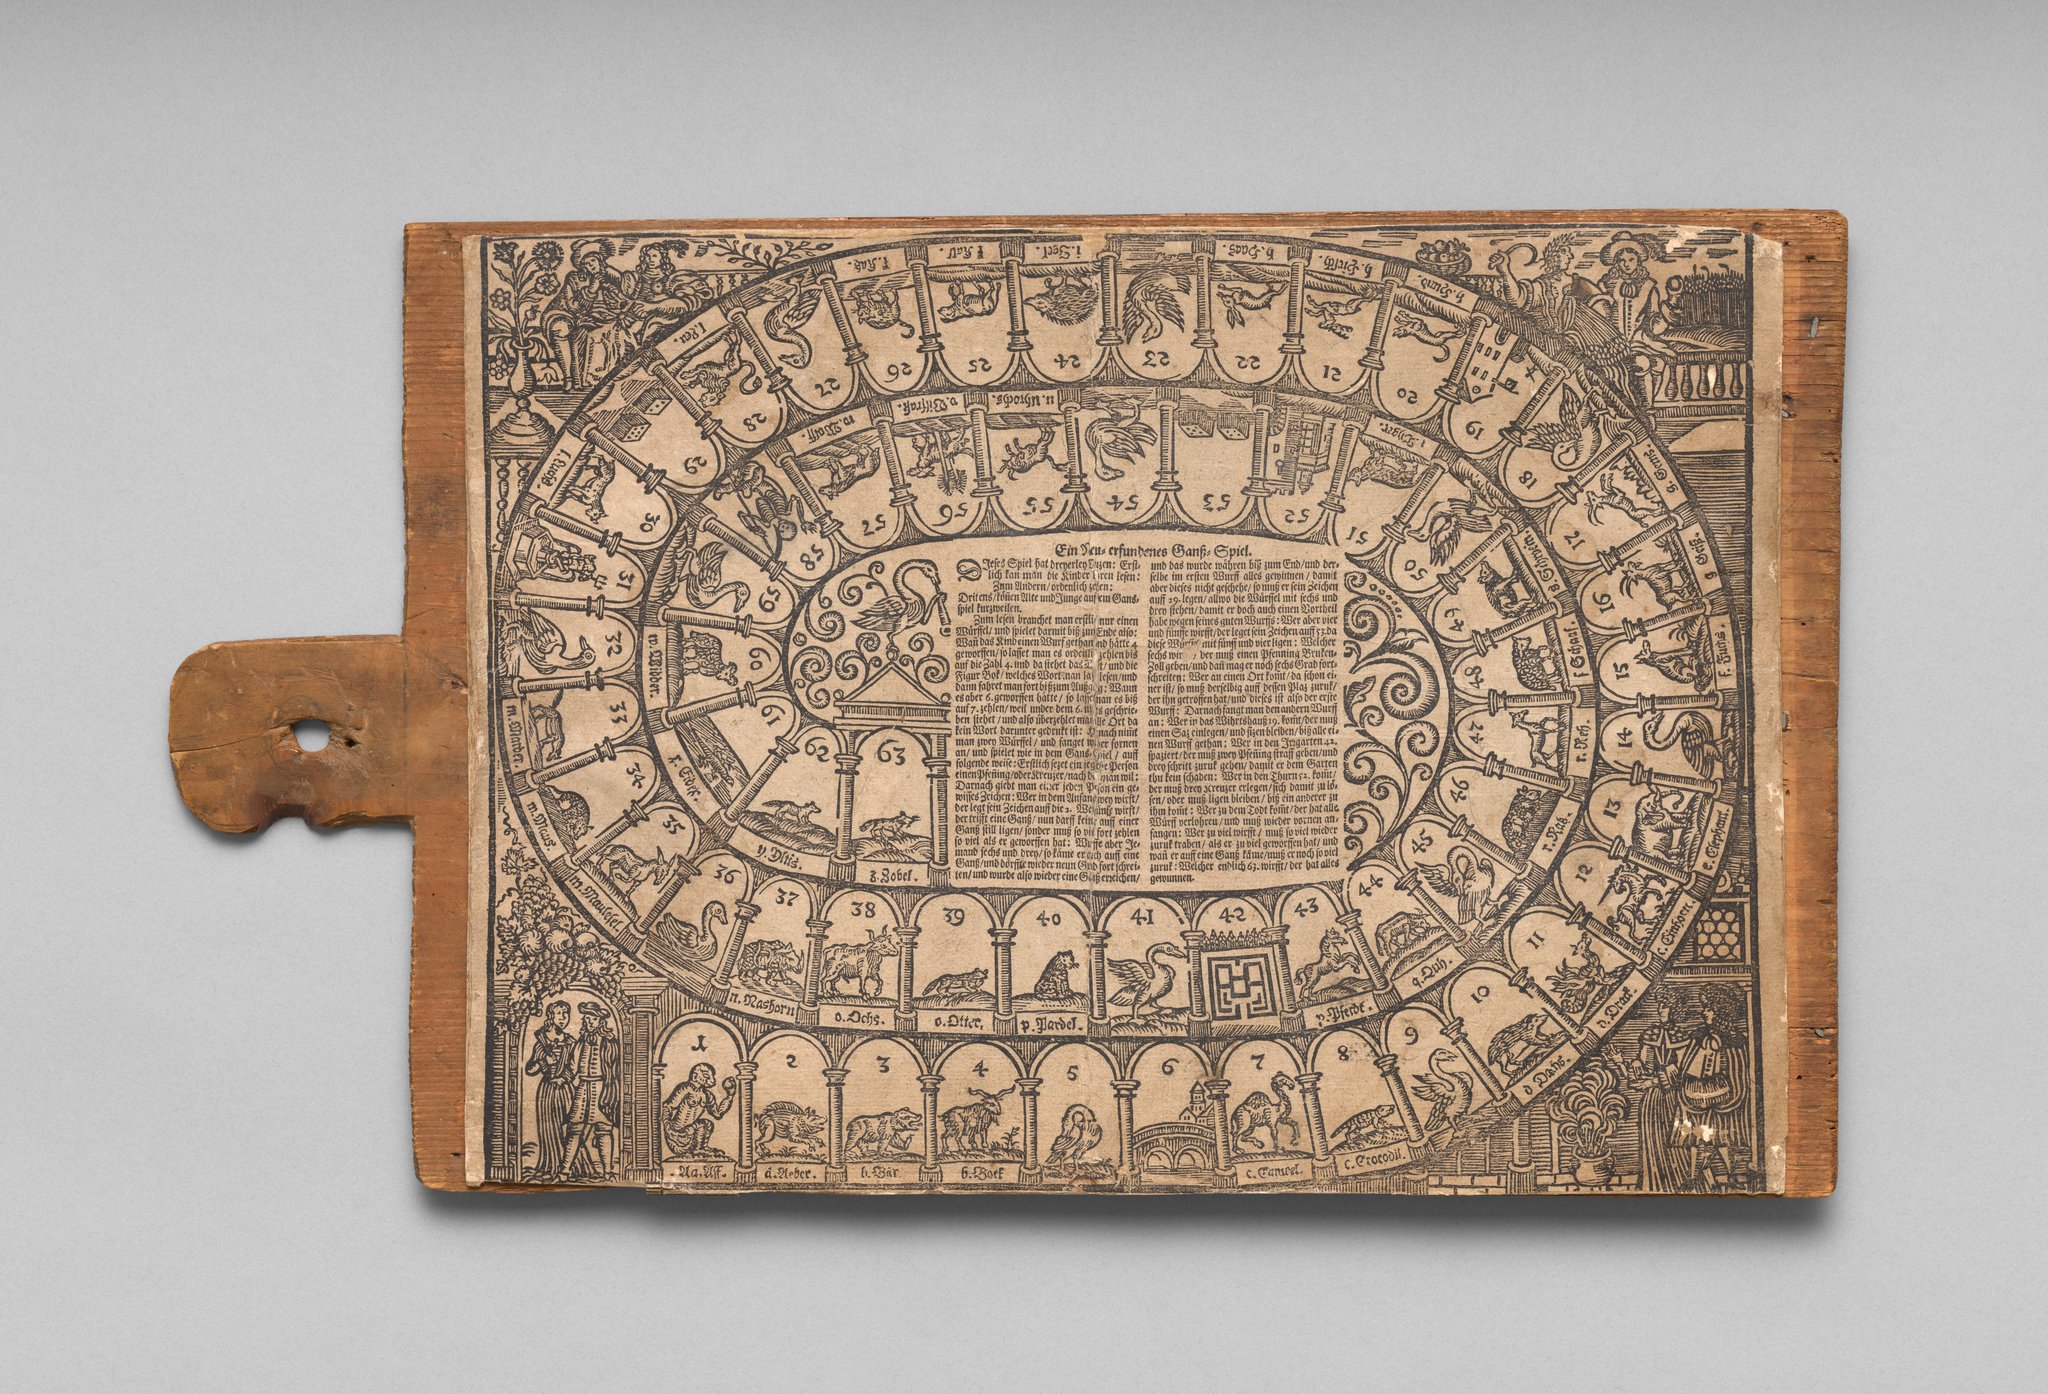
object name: gameboard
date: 1667-1733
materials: paper, wood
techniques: printing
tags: games